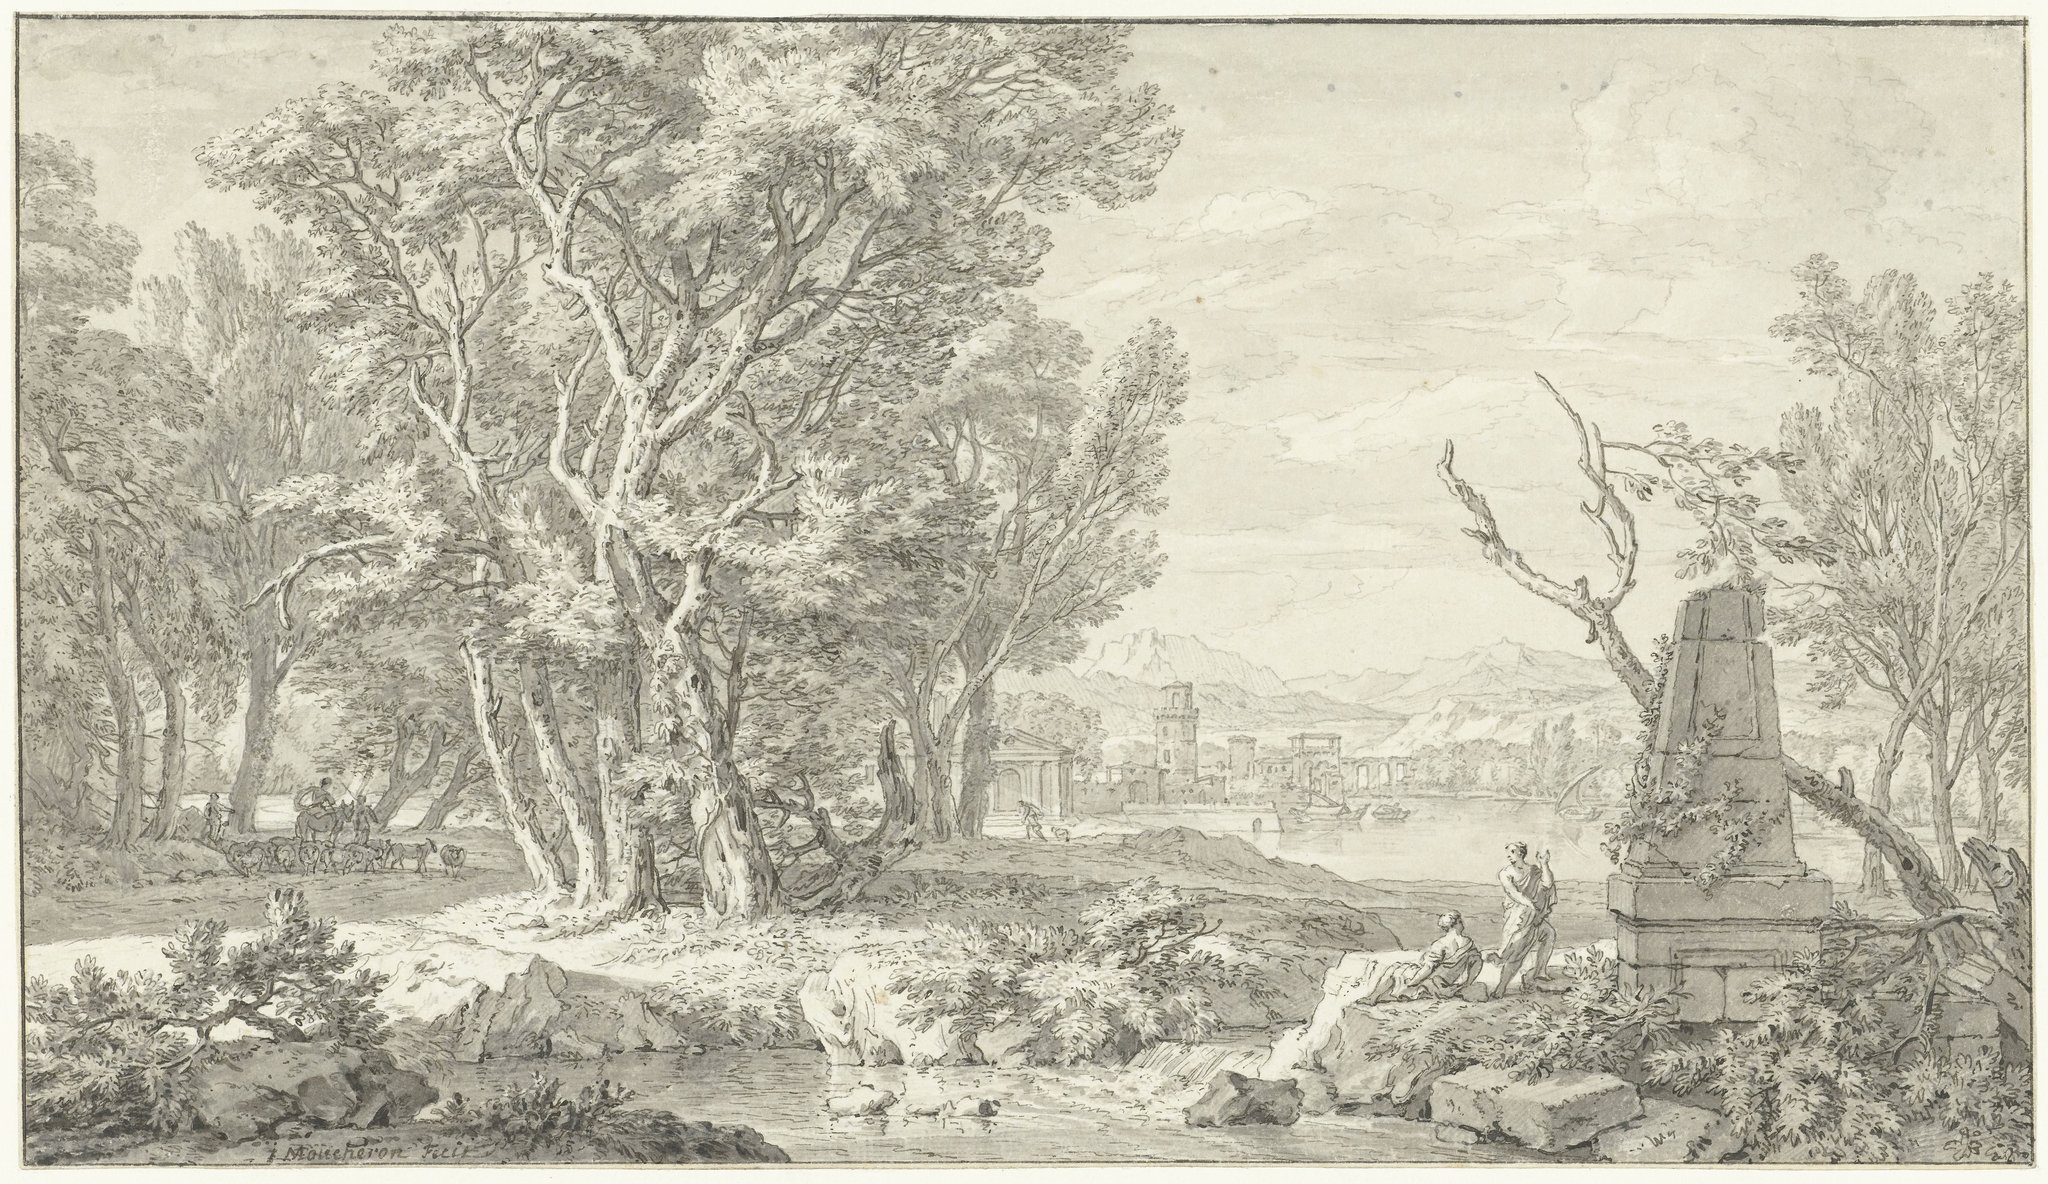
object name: drawing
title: Arcadisch landschap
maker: isaac de moucheron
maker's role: draughtsman, painter, print maker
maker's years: 1667-1744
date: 1677-1744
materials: ink, paper, pencil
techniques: brush, pen